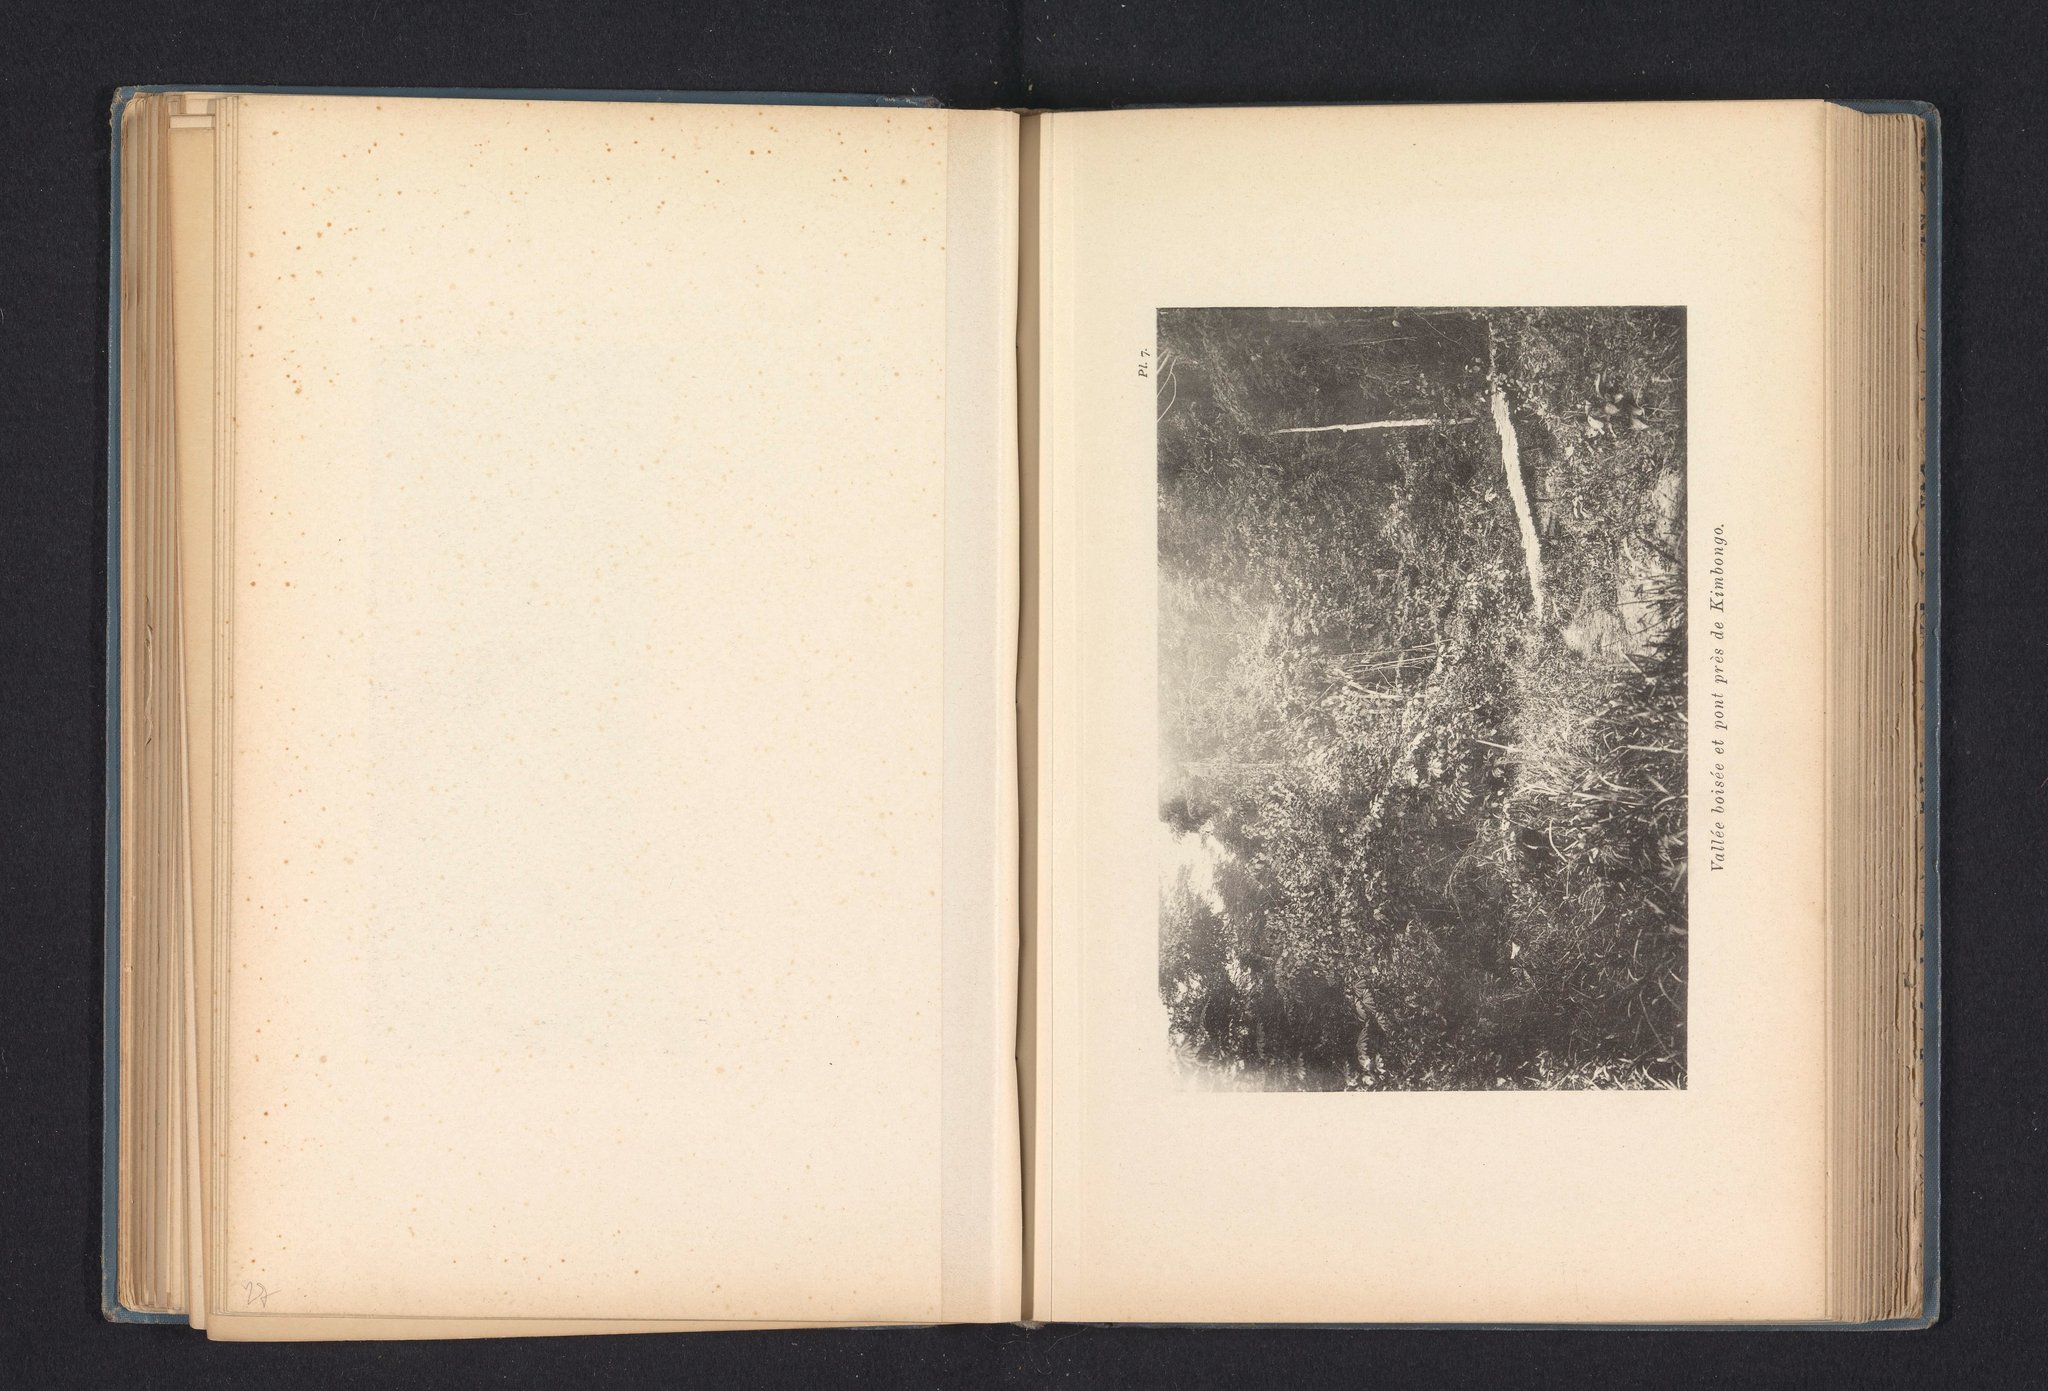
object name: photomechanical print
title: Vallei met een houten brug nabij Kimbongo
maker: franz thonner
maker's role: botanicus, ontdekkingsreiziger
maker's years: 1863-1928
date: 1896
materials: paper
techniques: photograph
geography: congo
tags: dale, valley, bridge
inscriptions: number: ‘Pl. 7.’